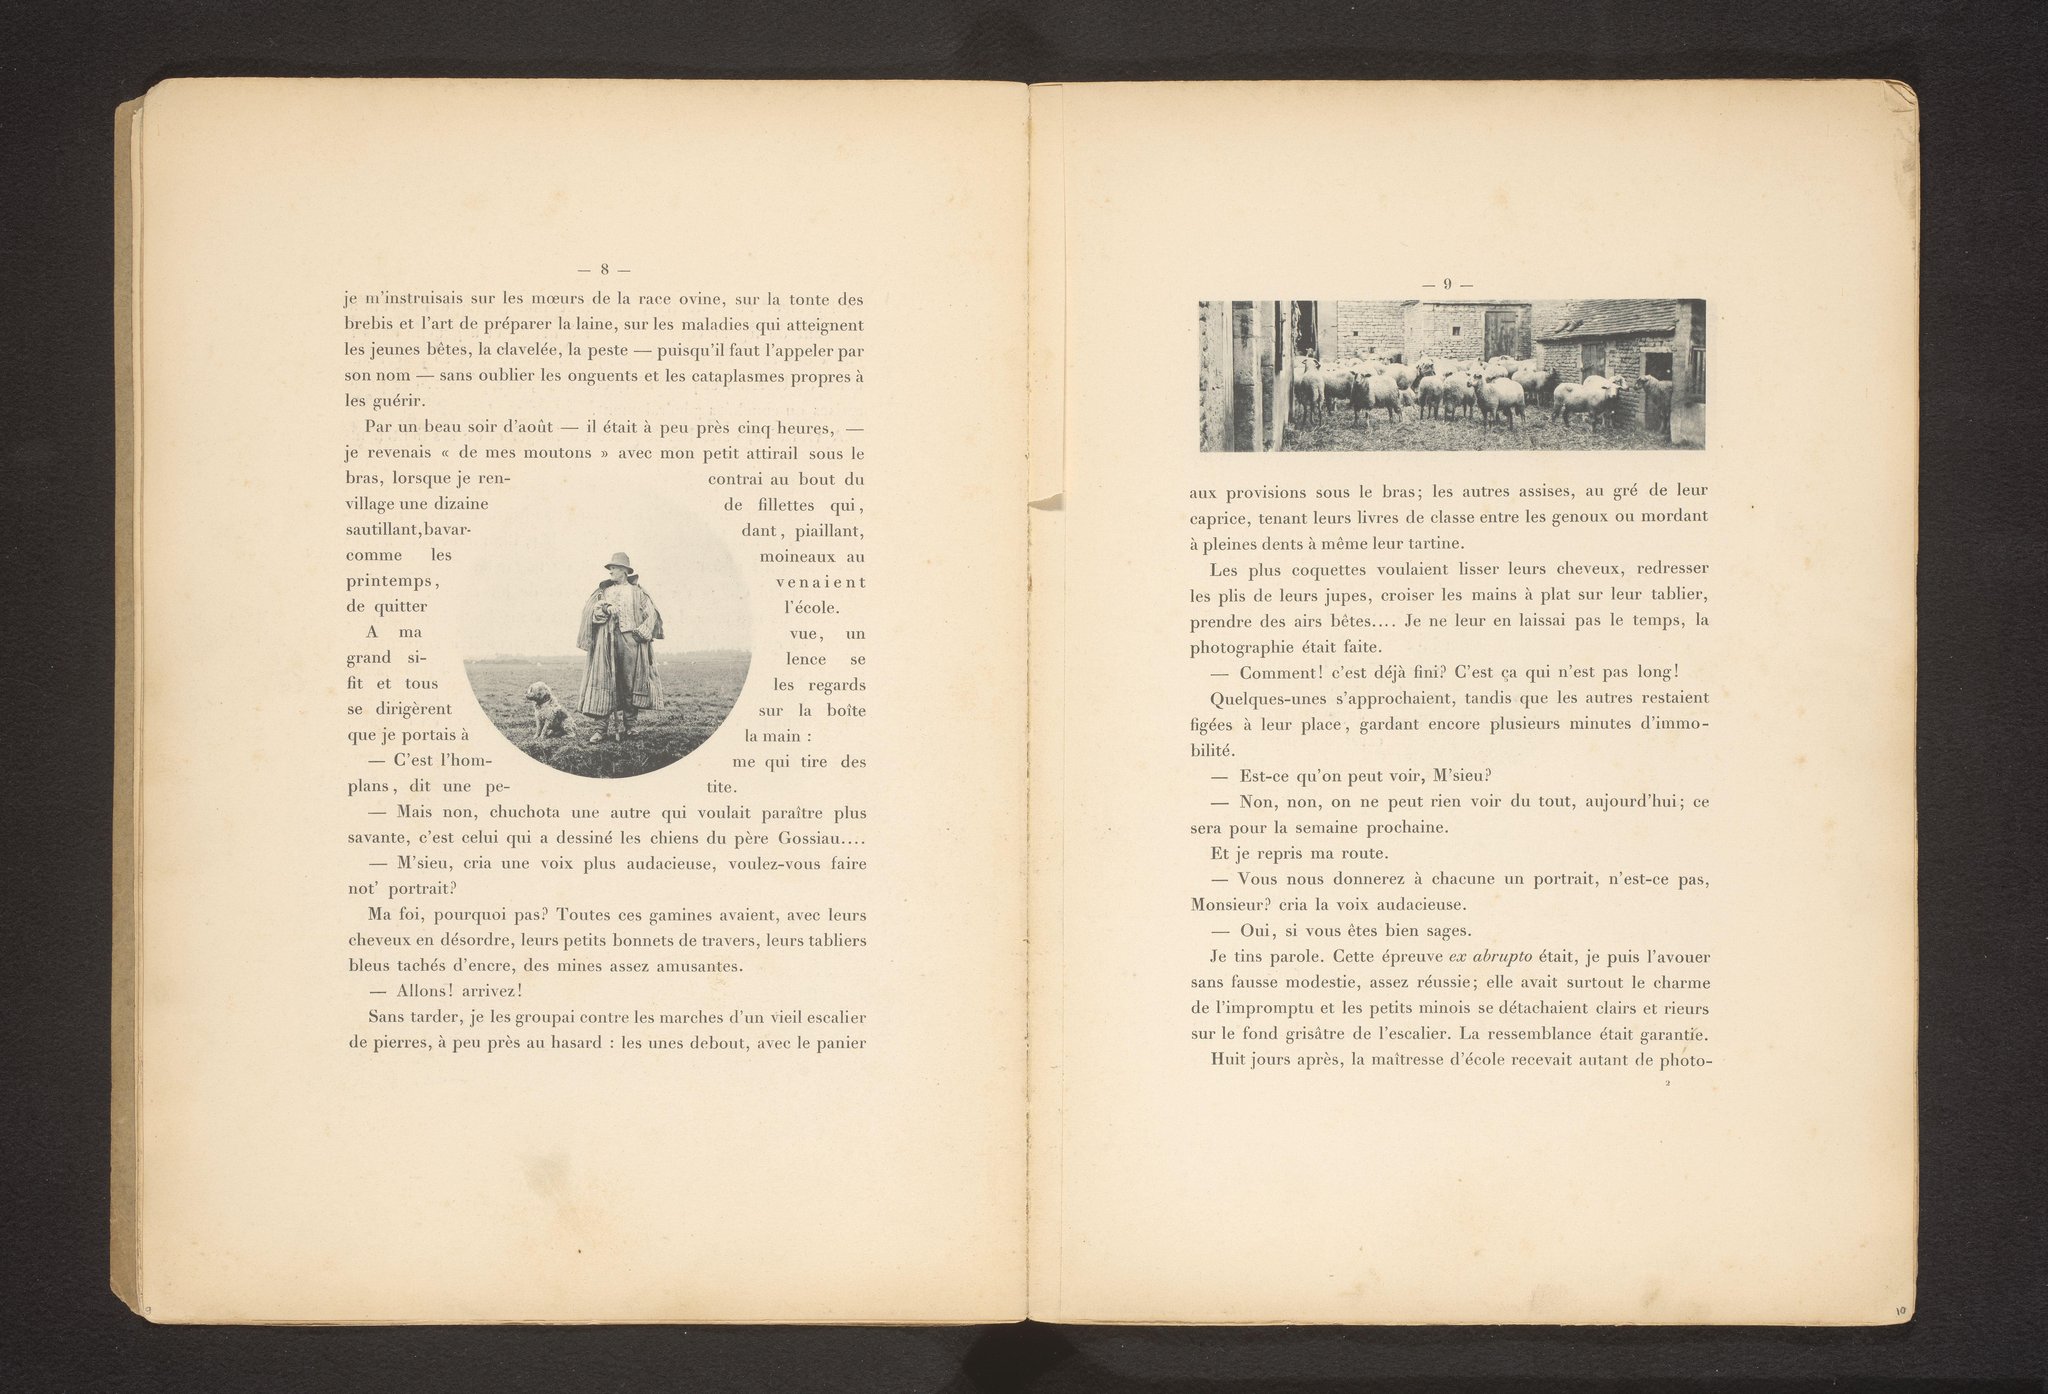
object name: photomechanical print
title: Kudde schapen voor een stal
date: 1885-1895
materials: paper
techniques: photograph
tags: sheep, cattle-breeding, livestock industry